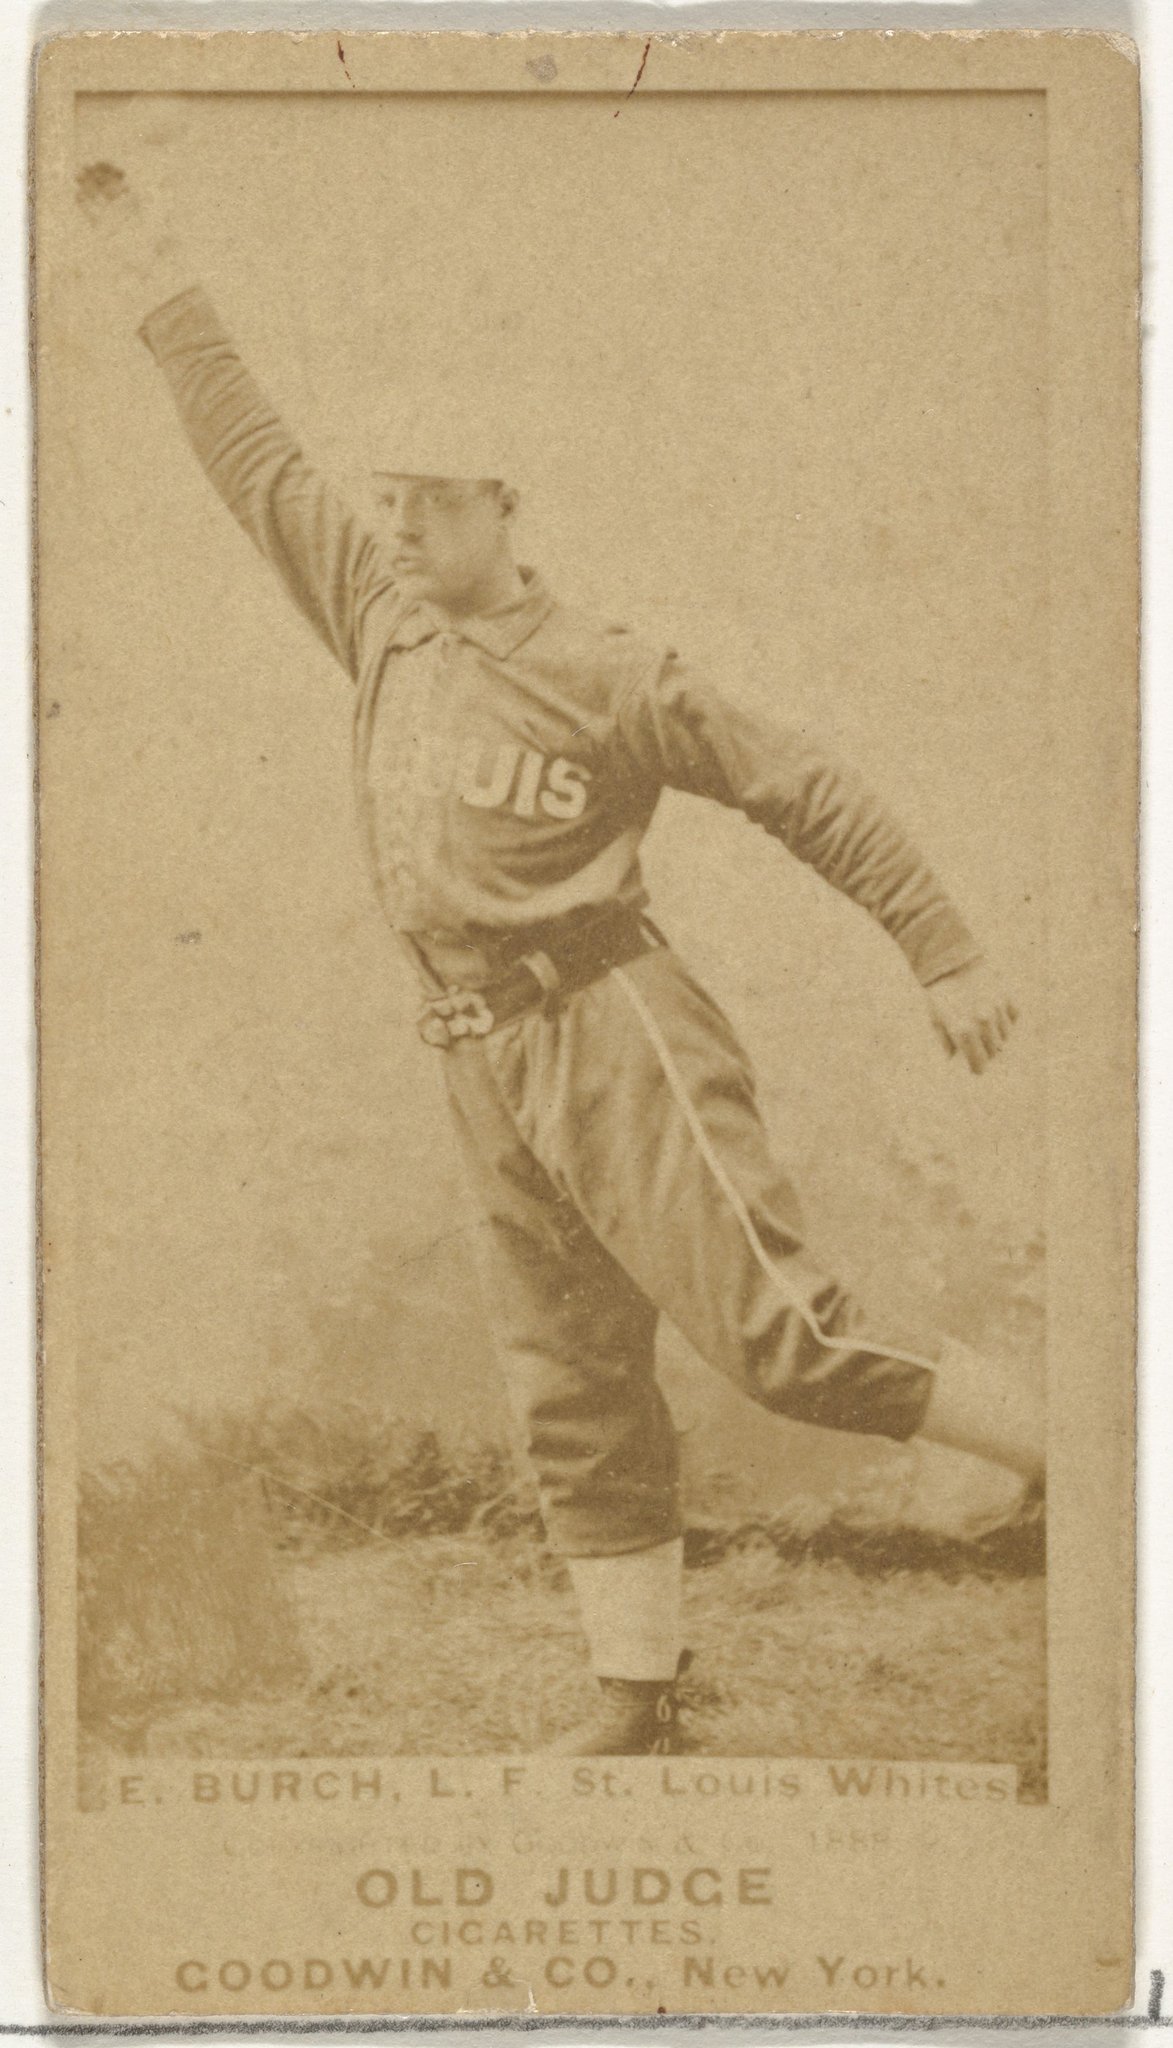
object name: baseball card, photograph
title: Burch, Left Field, St. Louis Whites, from the Old Judge series (N172) for Old Judge Cigarettes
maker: goodwin & company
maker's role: publisher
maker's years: 1850-1950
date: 1888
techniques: albumen silver print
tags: men,portraits,baseball,athletes